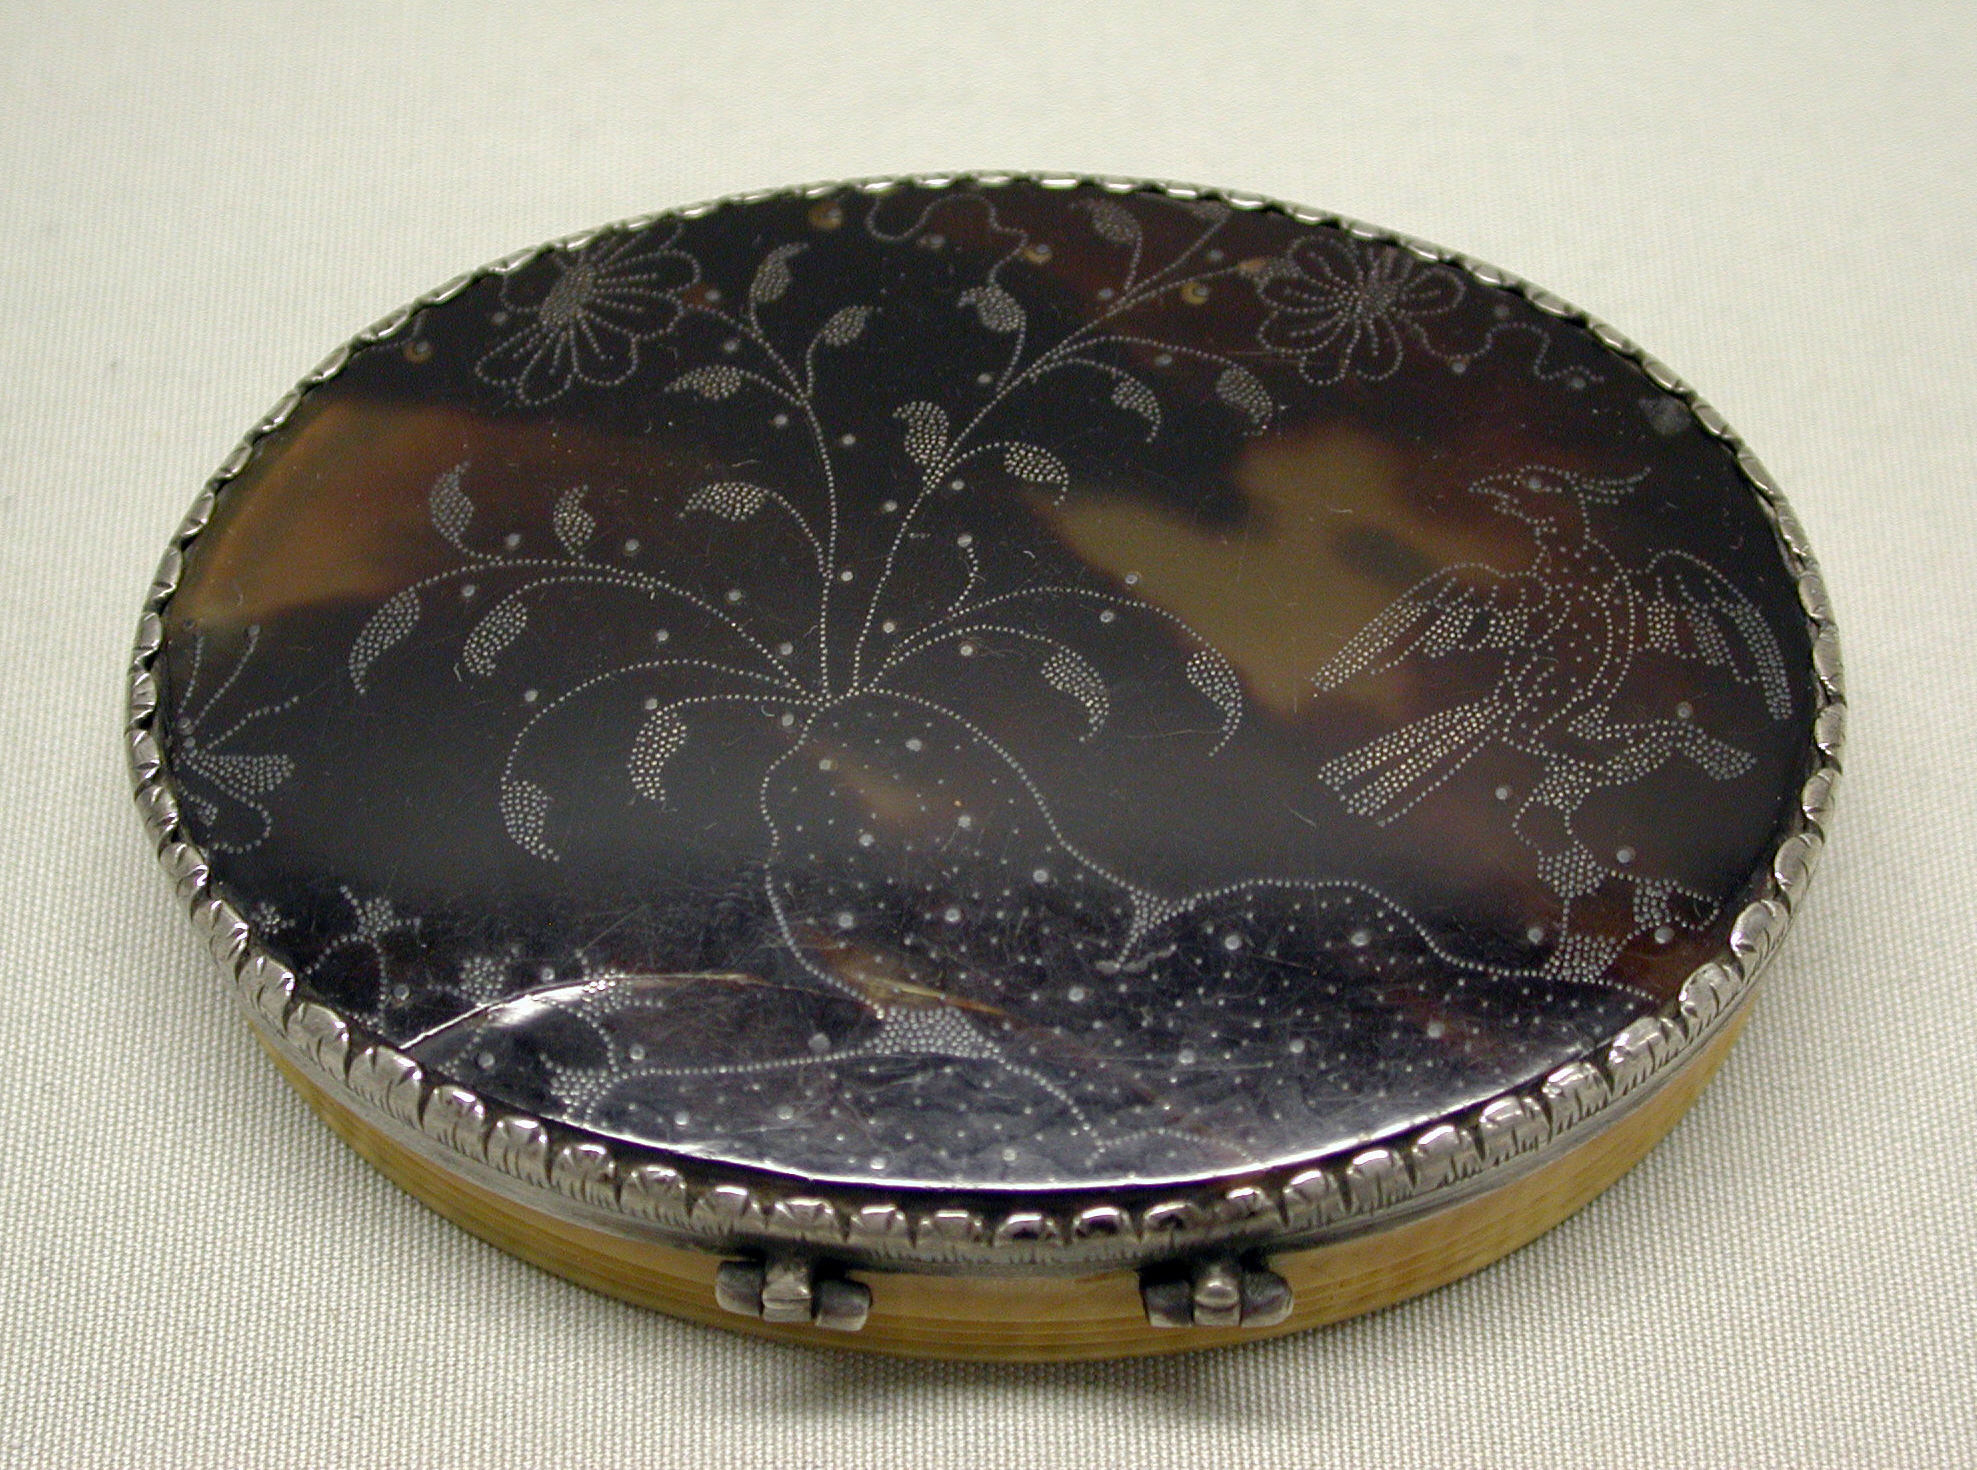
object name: box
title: Oval box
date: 1820-1830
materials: ivory, silver, shell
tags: birds,flowers,leaves